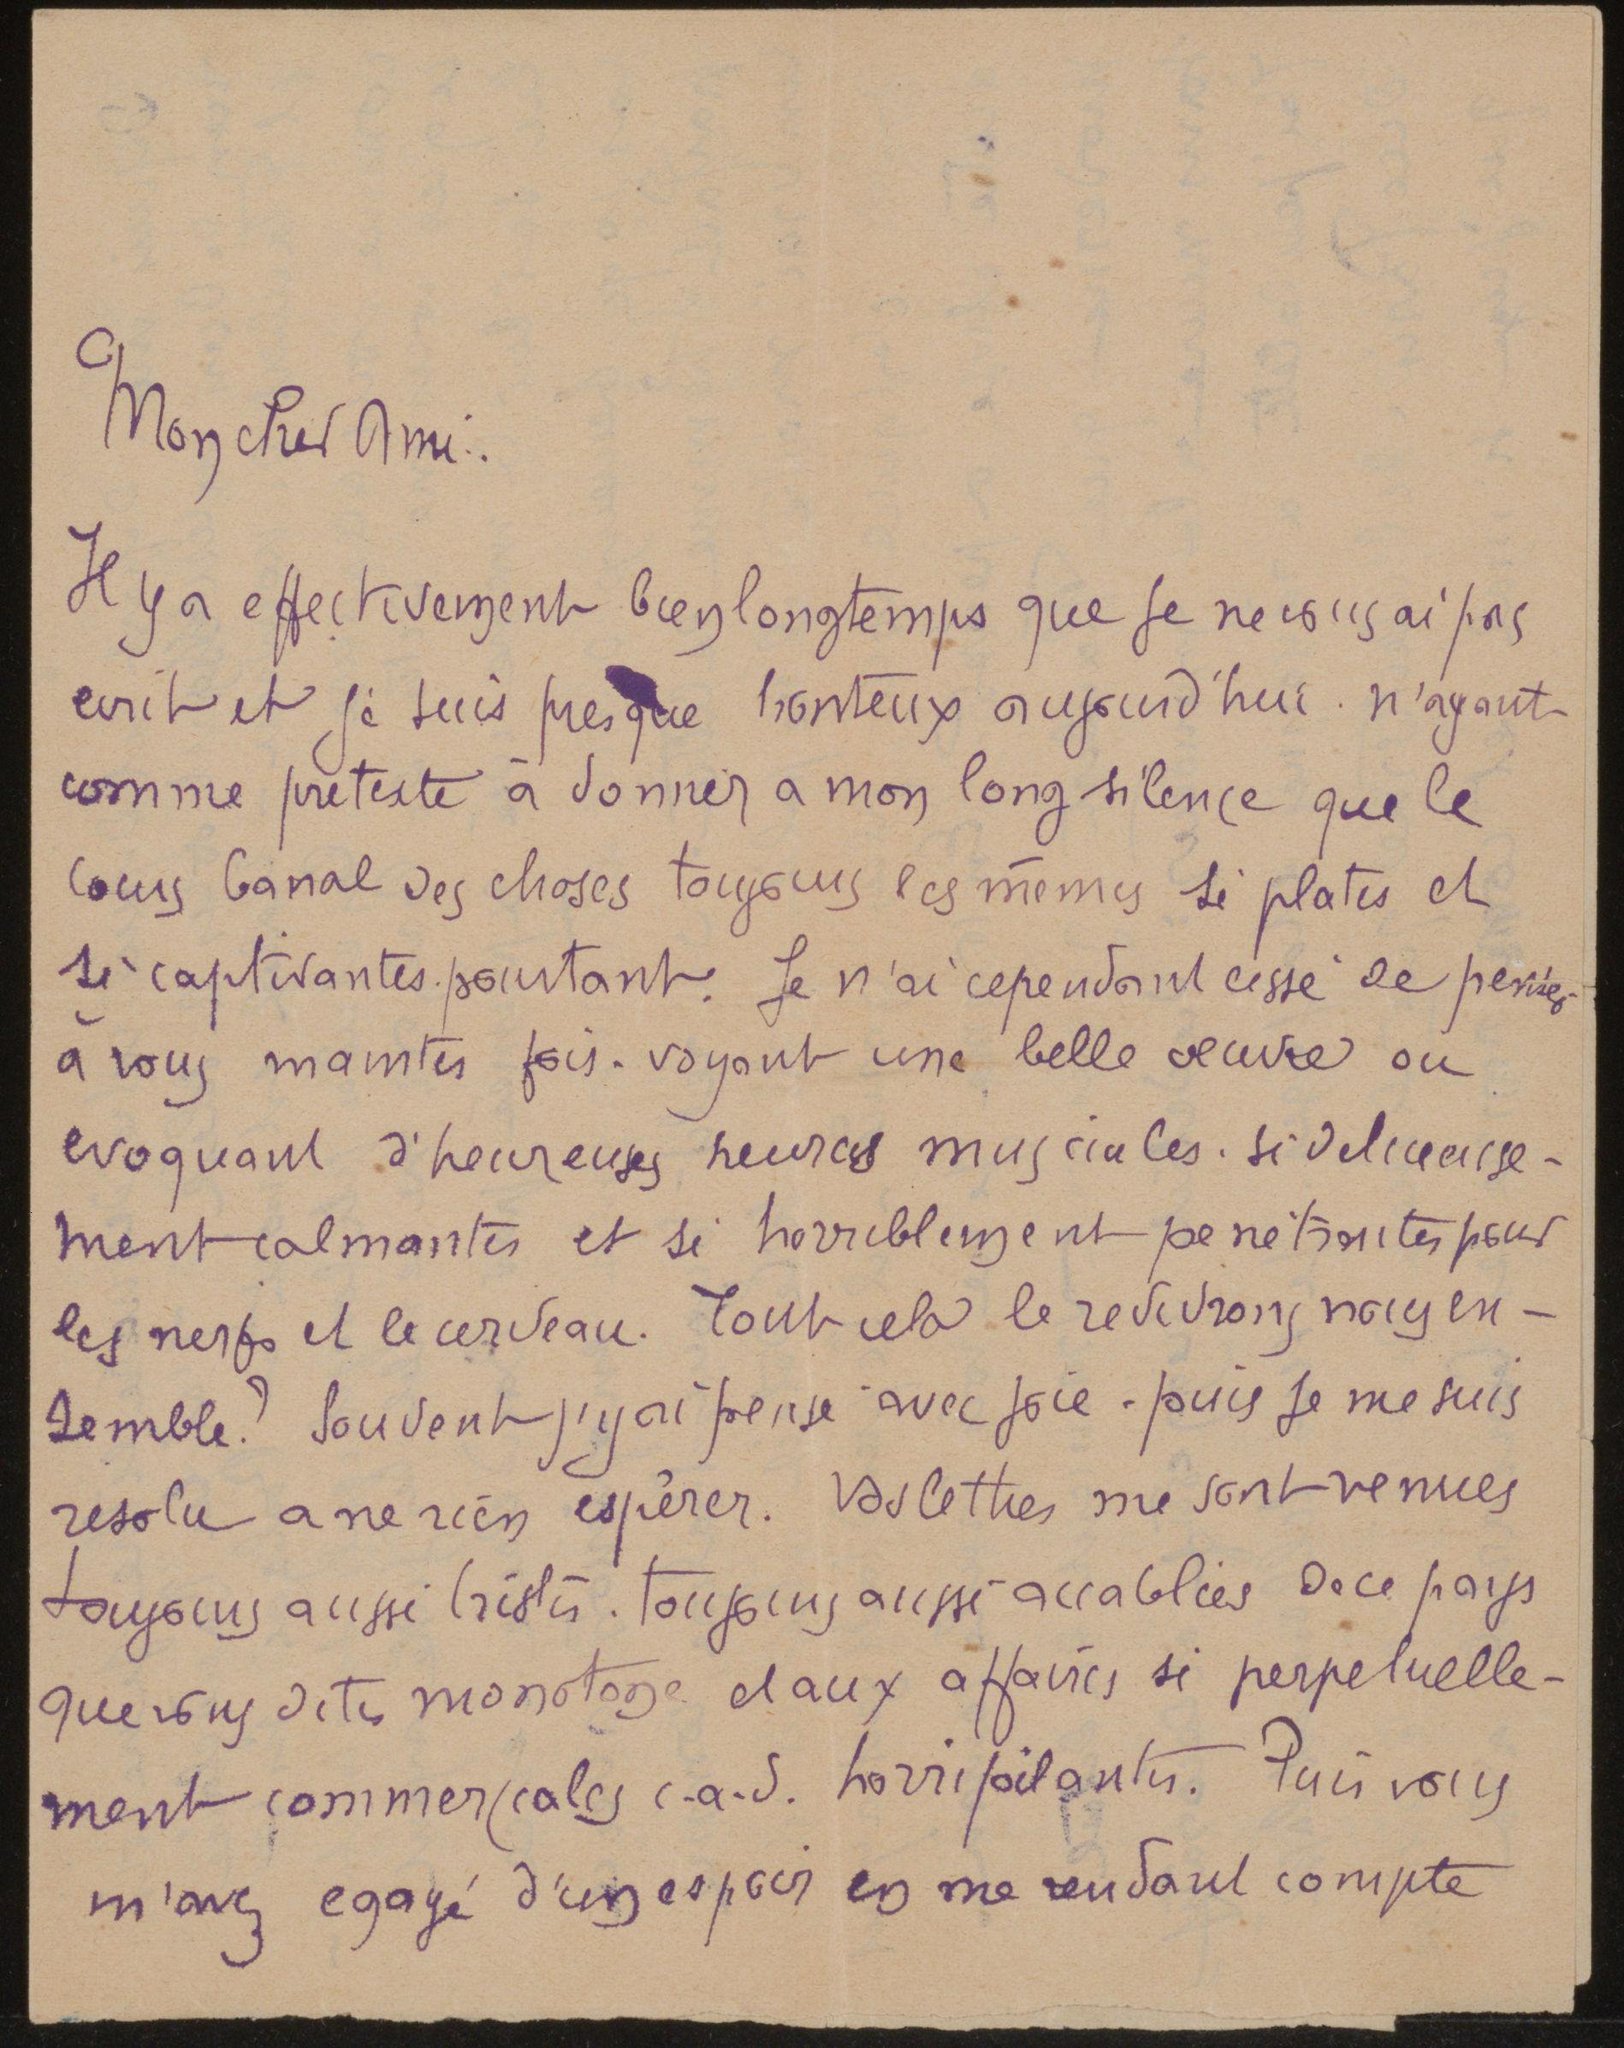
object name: letter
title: Brief aan Andries Bonger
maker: émile bernard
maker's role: print maker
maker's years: 1868-1941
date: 1892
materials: ink, paper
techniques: pen, writing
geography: pont-aven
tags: léon cladel, painter, draughtsman, vincent van gogh, paris, charles baudelaire, amsterdam, andries bonger, gustave flaubert, drawing, exhibition ~ art, france, holland, england, belgium